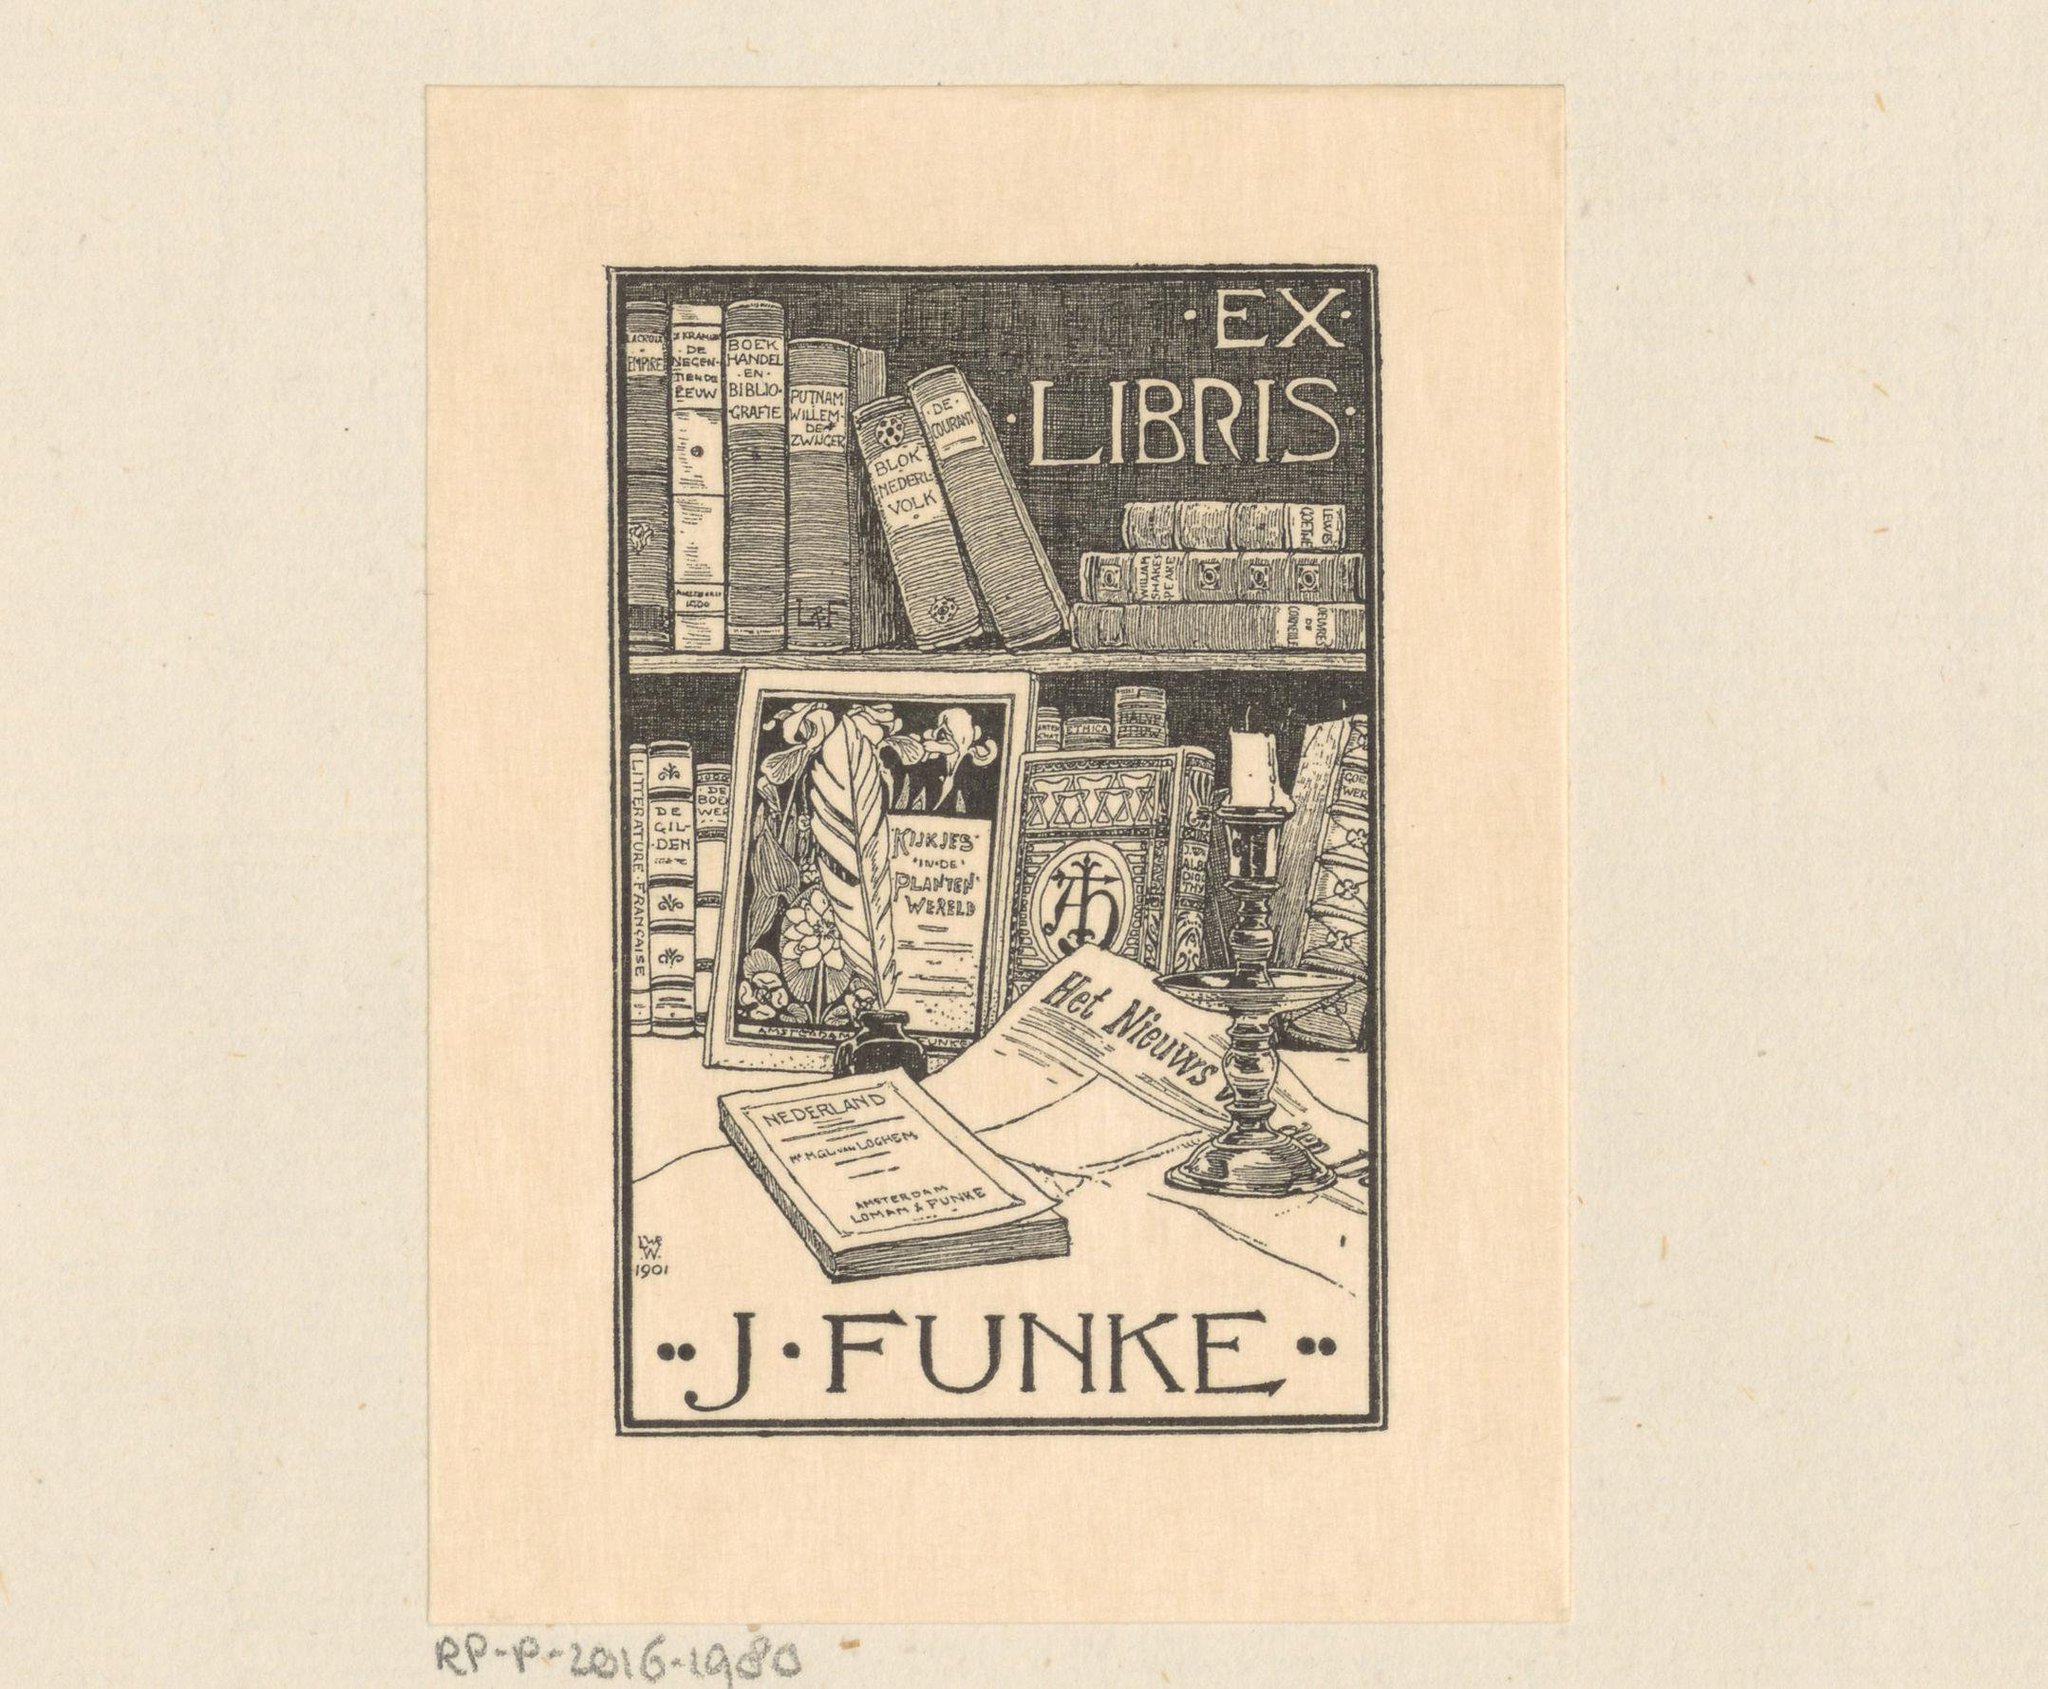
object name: bookplate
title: Ex libris van J. Funke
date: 1901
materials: paper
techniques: printing block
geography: netherlands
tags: amsterdam, the hague, publisher, book, publishing, publisher, newspaper, news-sheet, candlestick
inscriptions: date